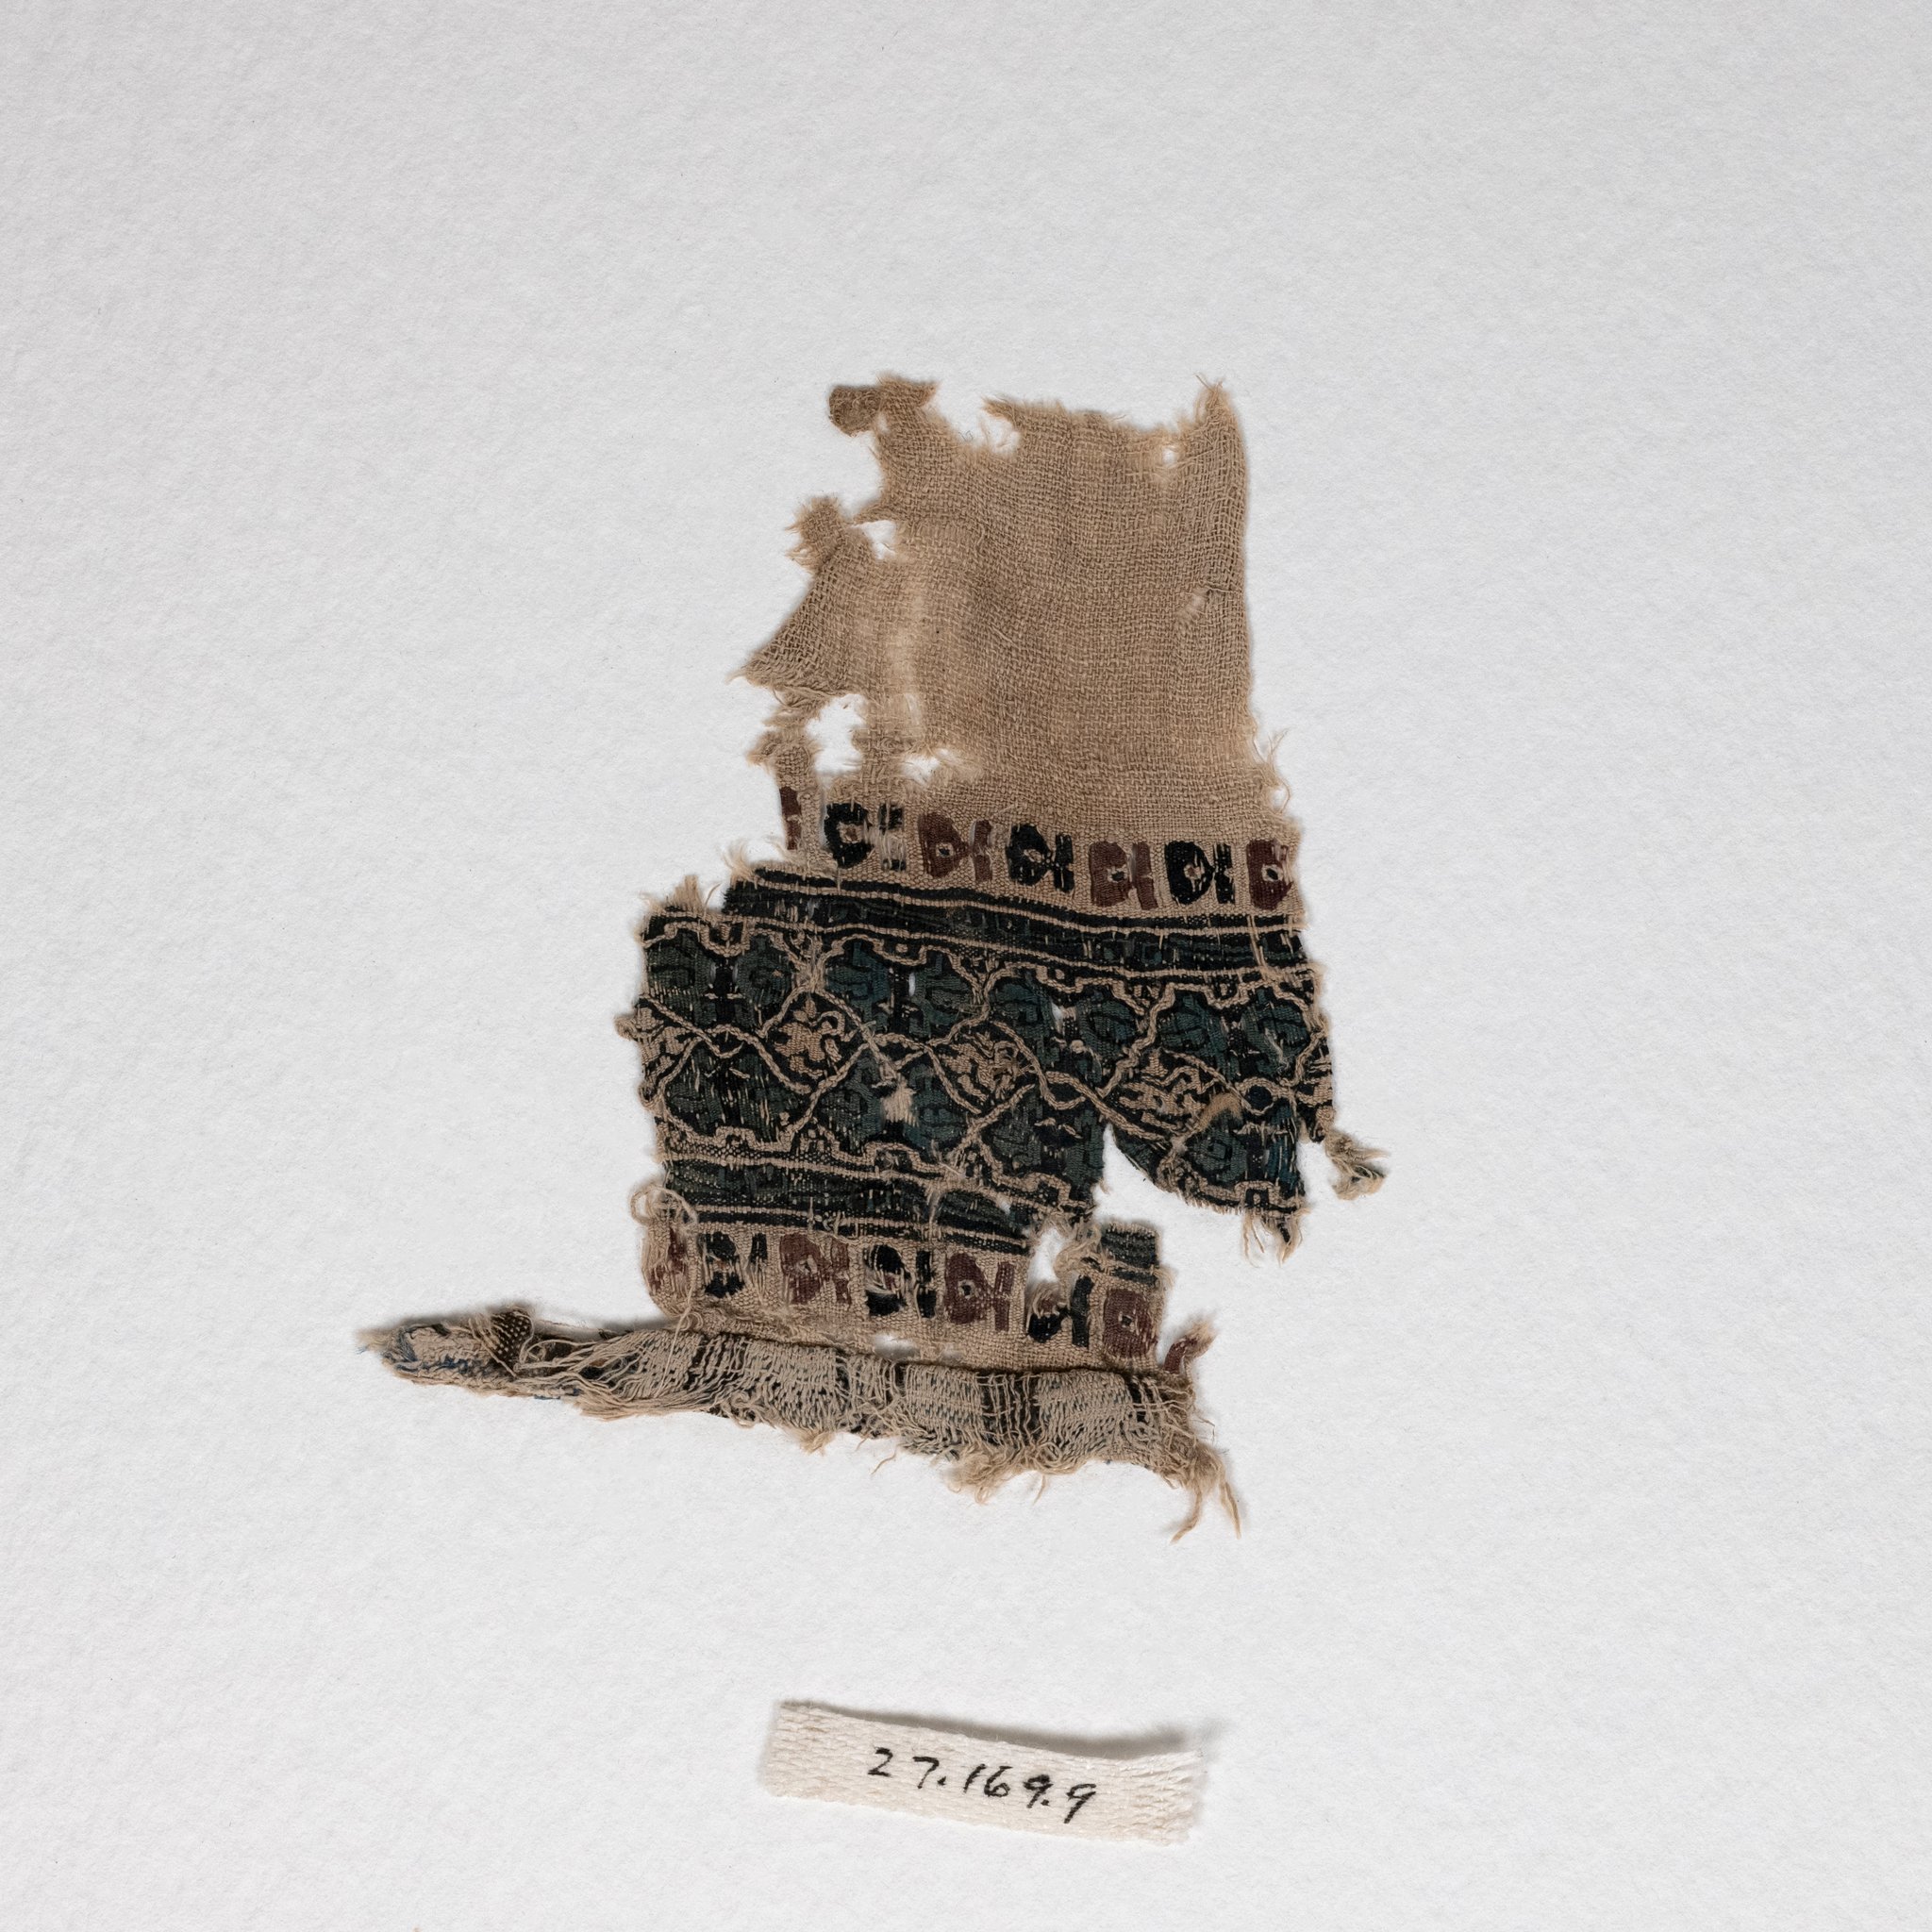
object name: textile fragment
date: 1101-1200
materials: linen, silk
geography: egypt